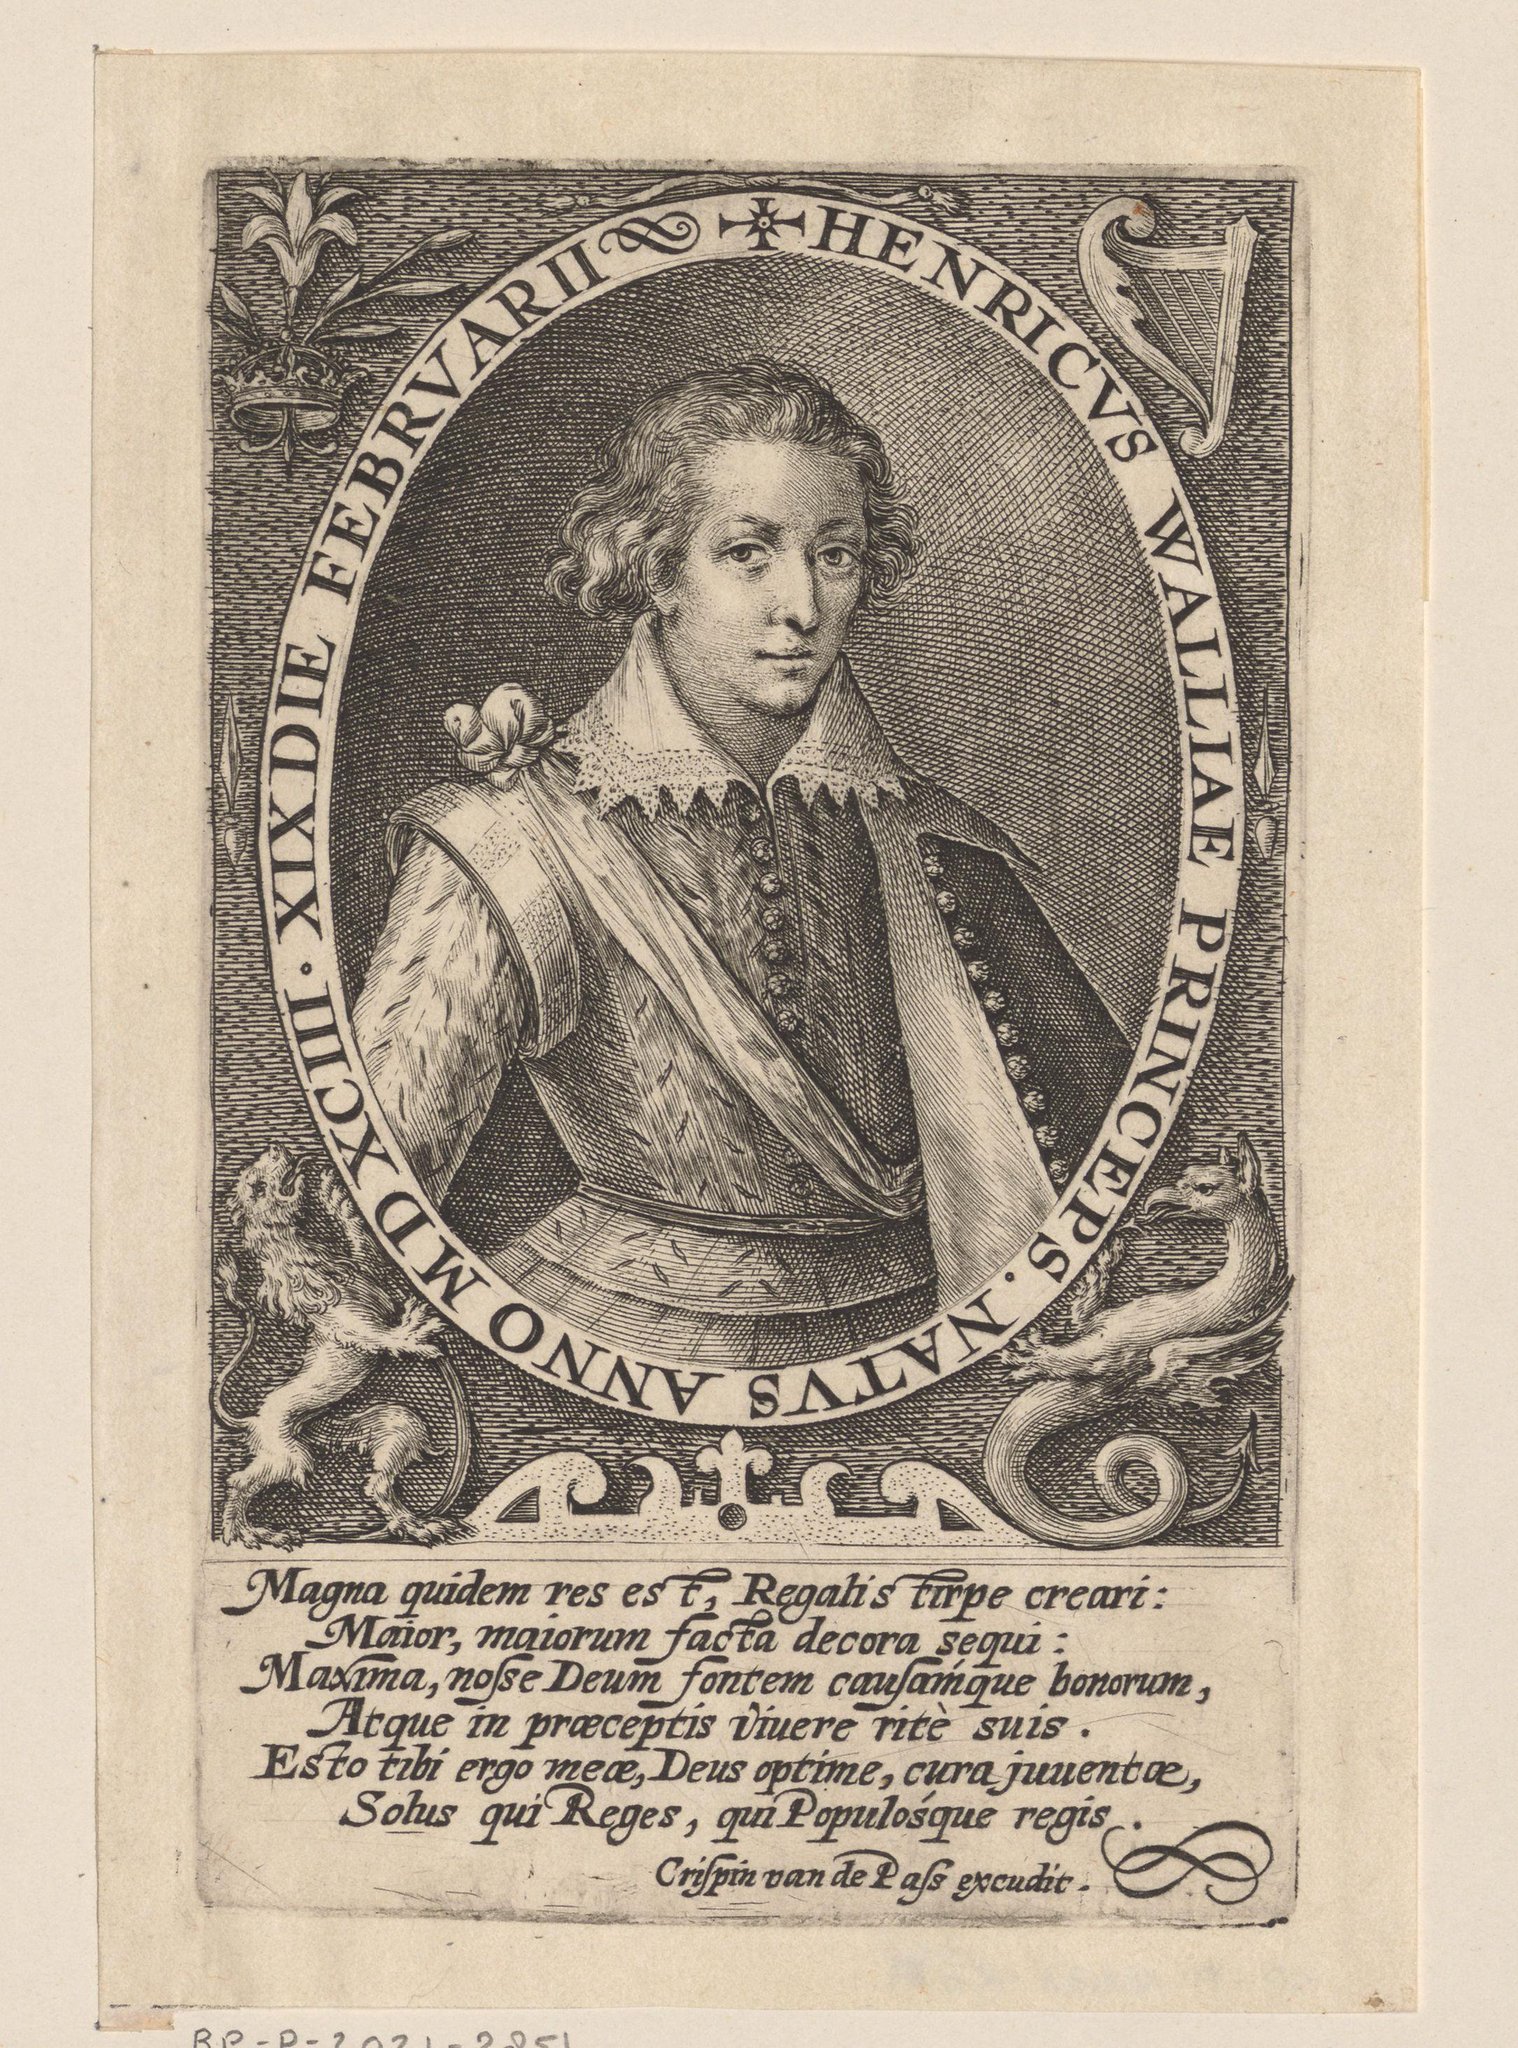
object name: print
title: Portret van Hendrik Frederik Stuart, prins van Wales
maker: crispijn van de passe (i)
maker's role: draughtsman, print maker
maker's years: 1564-1637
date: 1574-1637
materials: paper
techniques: engraving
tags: prince, historical persons